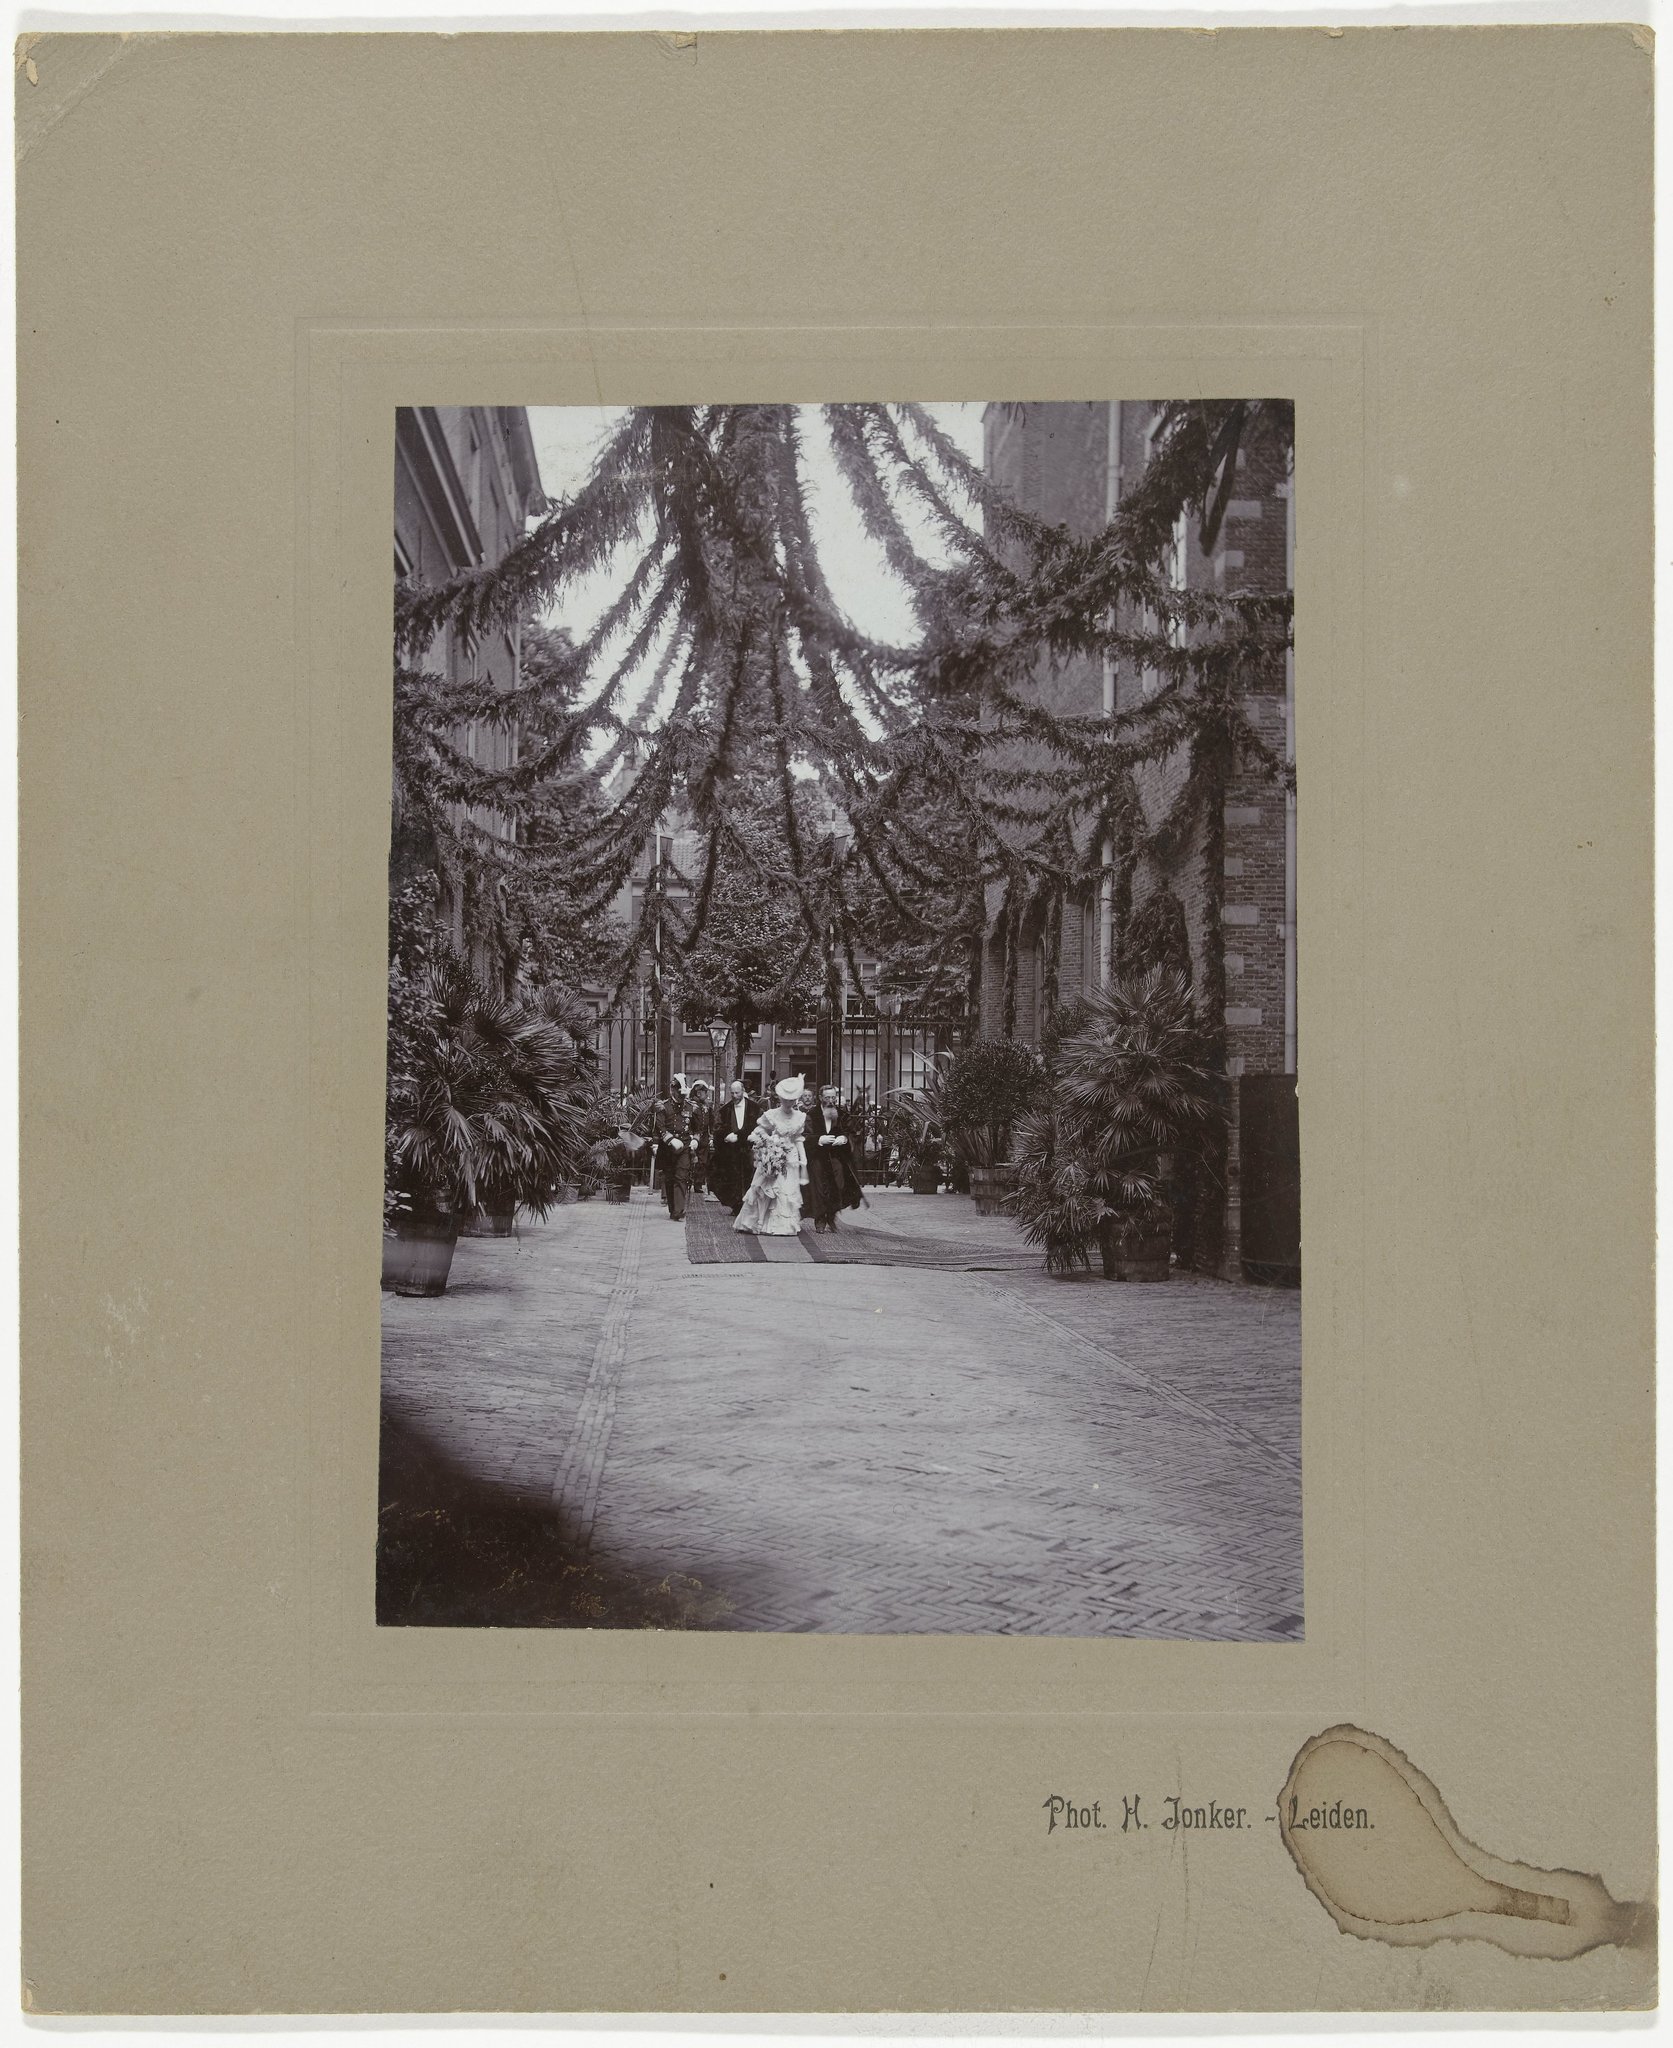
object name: photograph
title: Aankomst van koningin Wilhelmina bij het academiegebouw van de universiteit te Leiden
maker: hendrik jonker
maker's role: fotograaf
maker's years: 1846-1932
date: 1898-1915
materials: cardboard, paper, photographic support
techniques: collodion silver print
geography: leiden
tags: the hague, wilhelmina of the netherlands, university building, college, university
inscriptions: name: ‘C. Vosmaer, Rapenburg 83, Leiden’, name: ‘Vosmaer’, signature: ‘Phot,. H Jonker - Leiden’